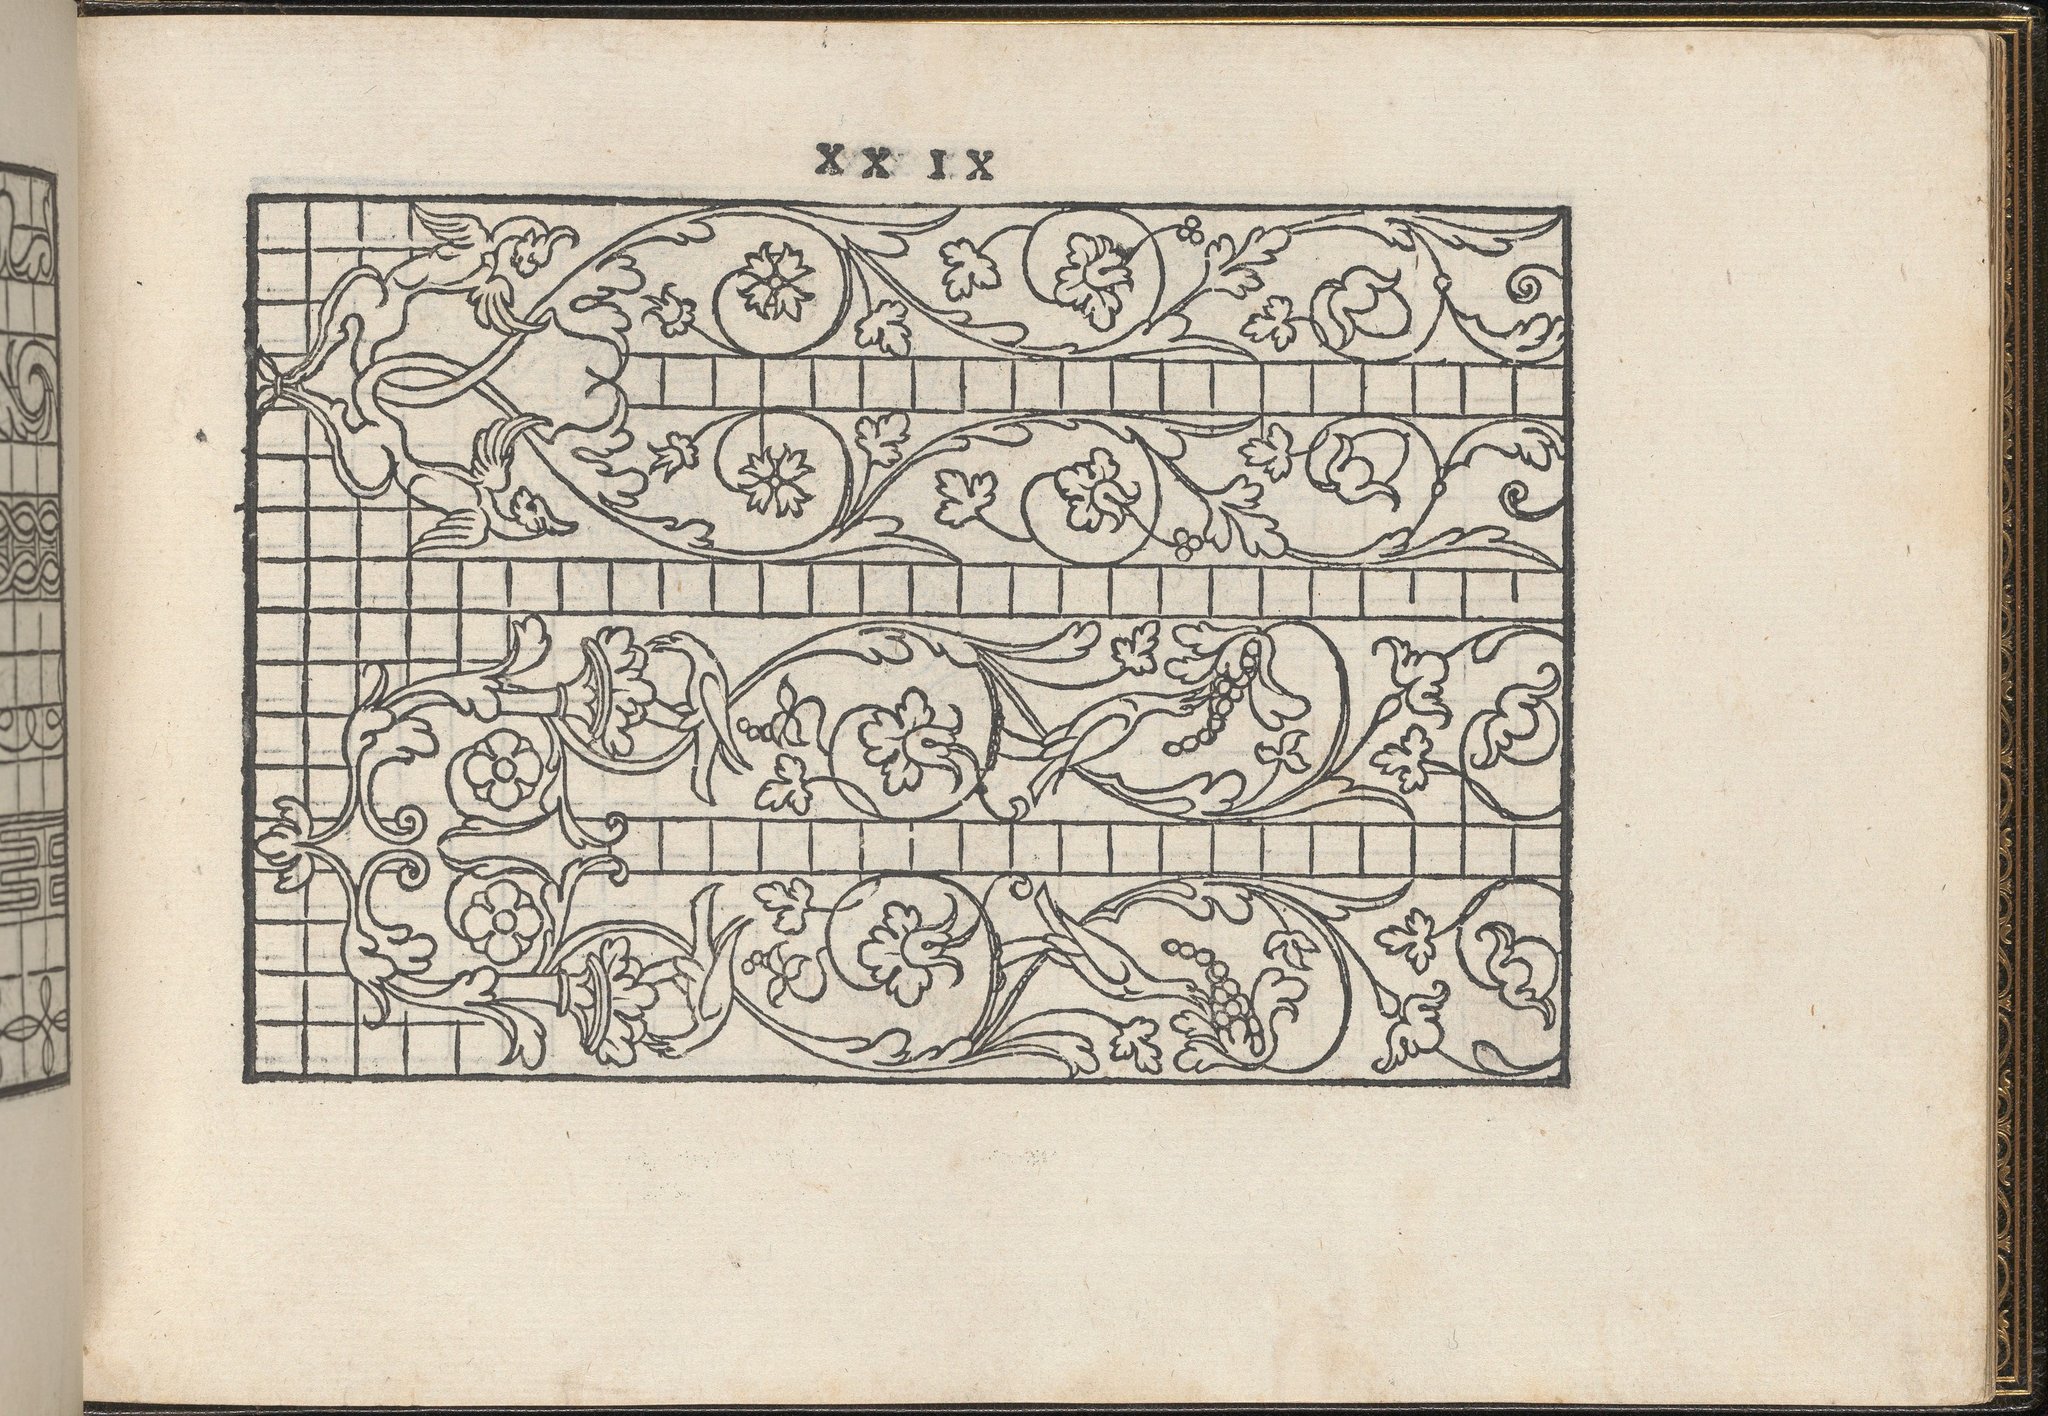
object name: book print ornament architecture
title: La Vera Perfettione del Disegno di varie sorti di recami, page 15 (recto)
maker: giovanni ostaus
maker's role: publisher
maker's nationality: italian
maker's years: 1507-1607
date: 1567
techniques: woodcut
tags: ornament